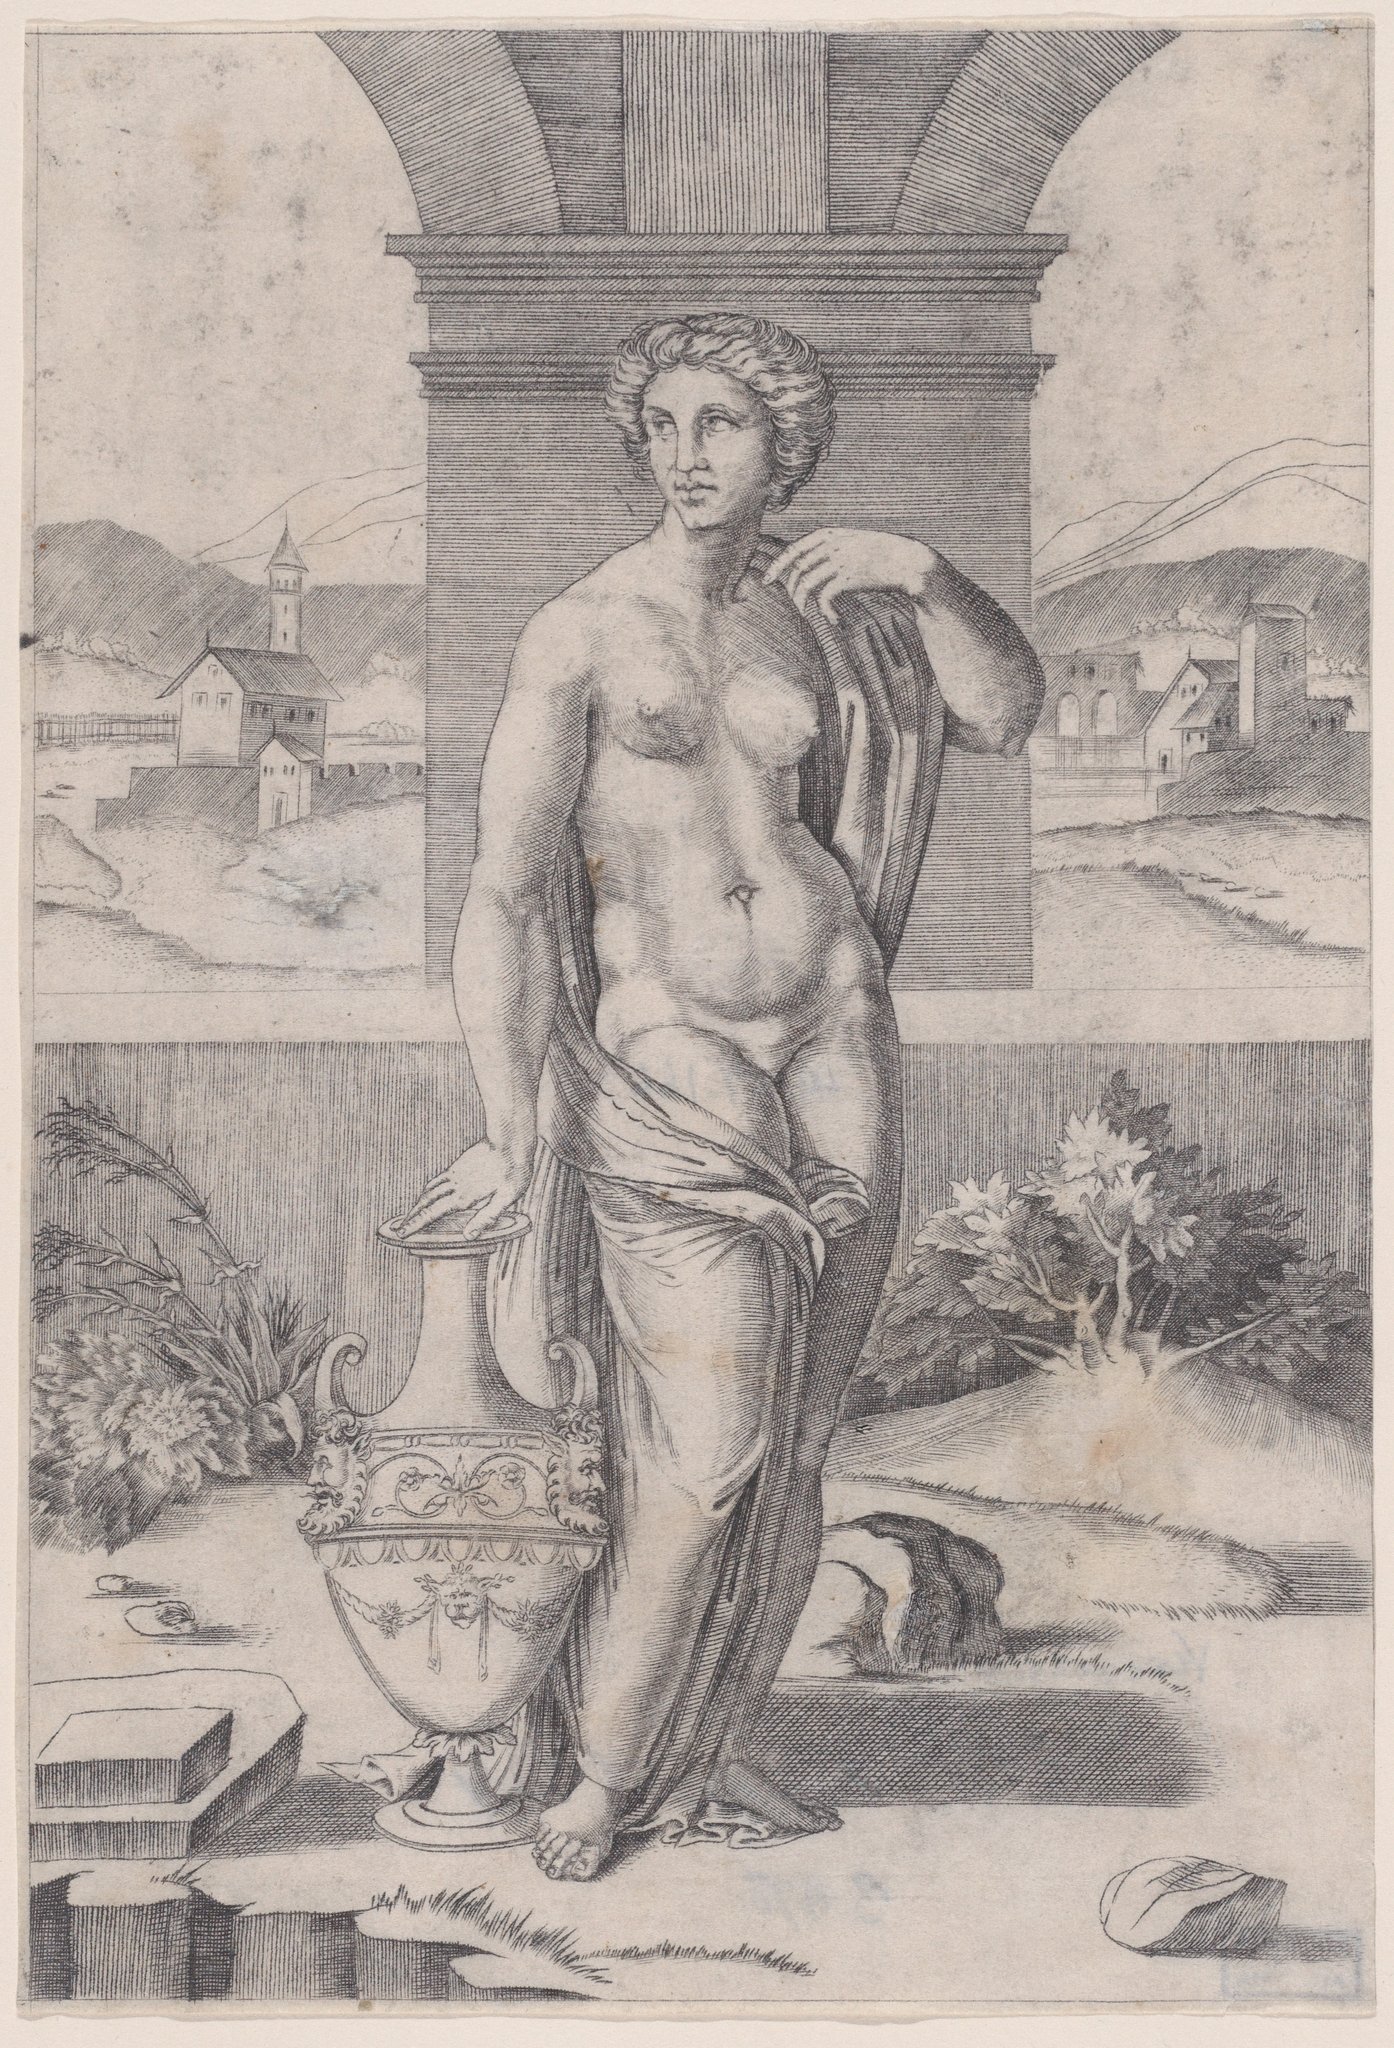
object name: print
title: Woman Standing near a Vase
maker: agostino veneziano (agostino dei musi)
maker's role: artist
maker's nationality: italian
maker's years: 1490-1536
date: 1514-1536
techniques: engraving